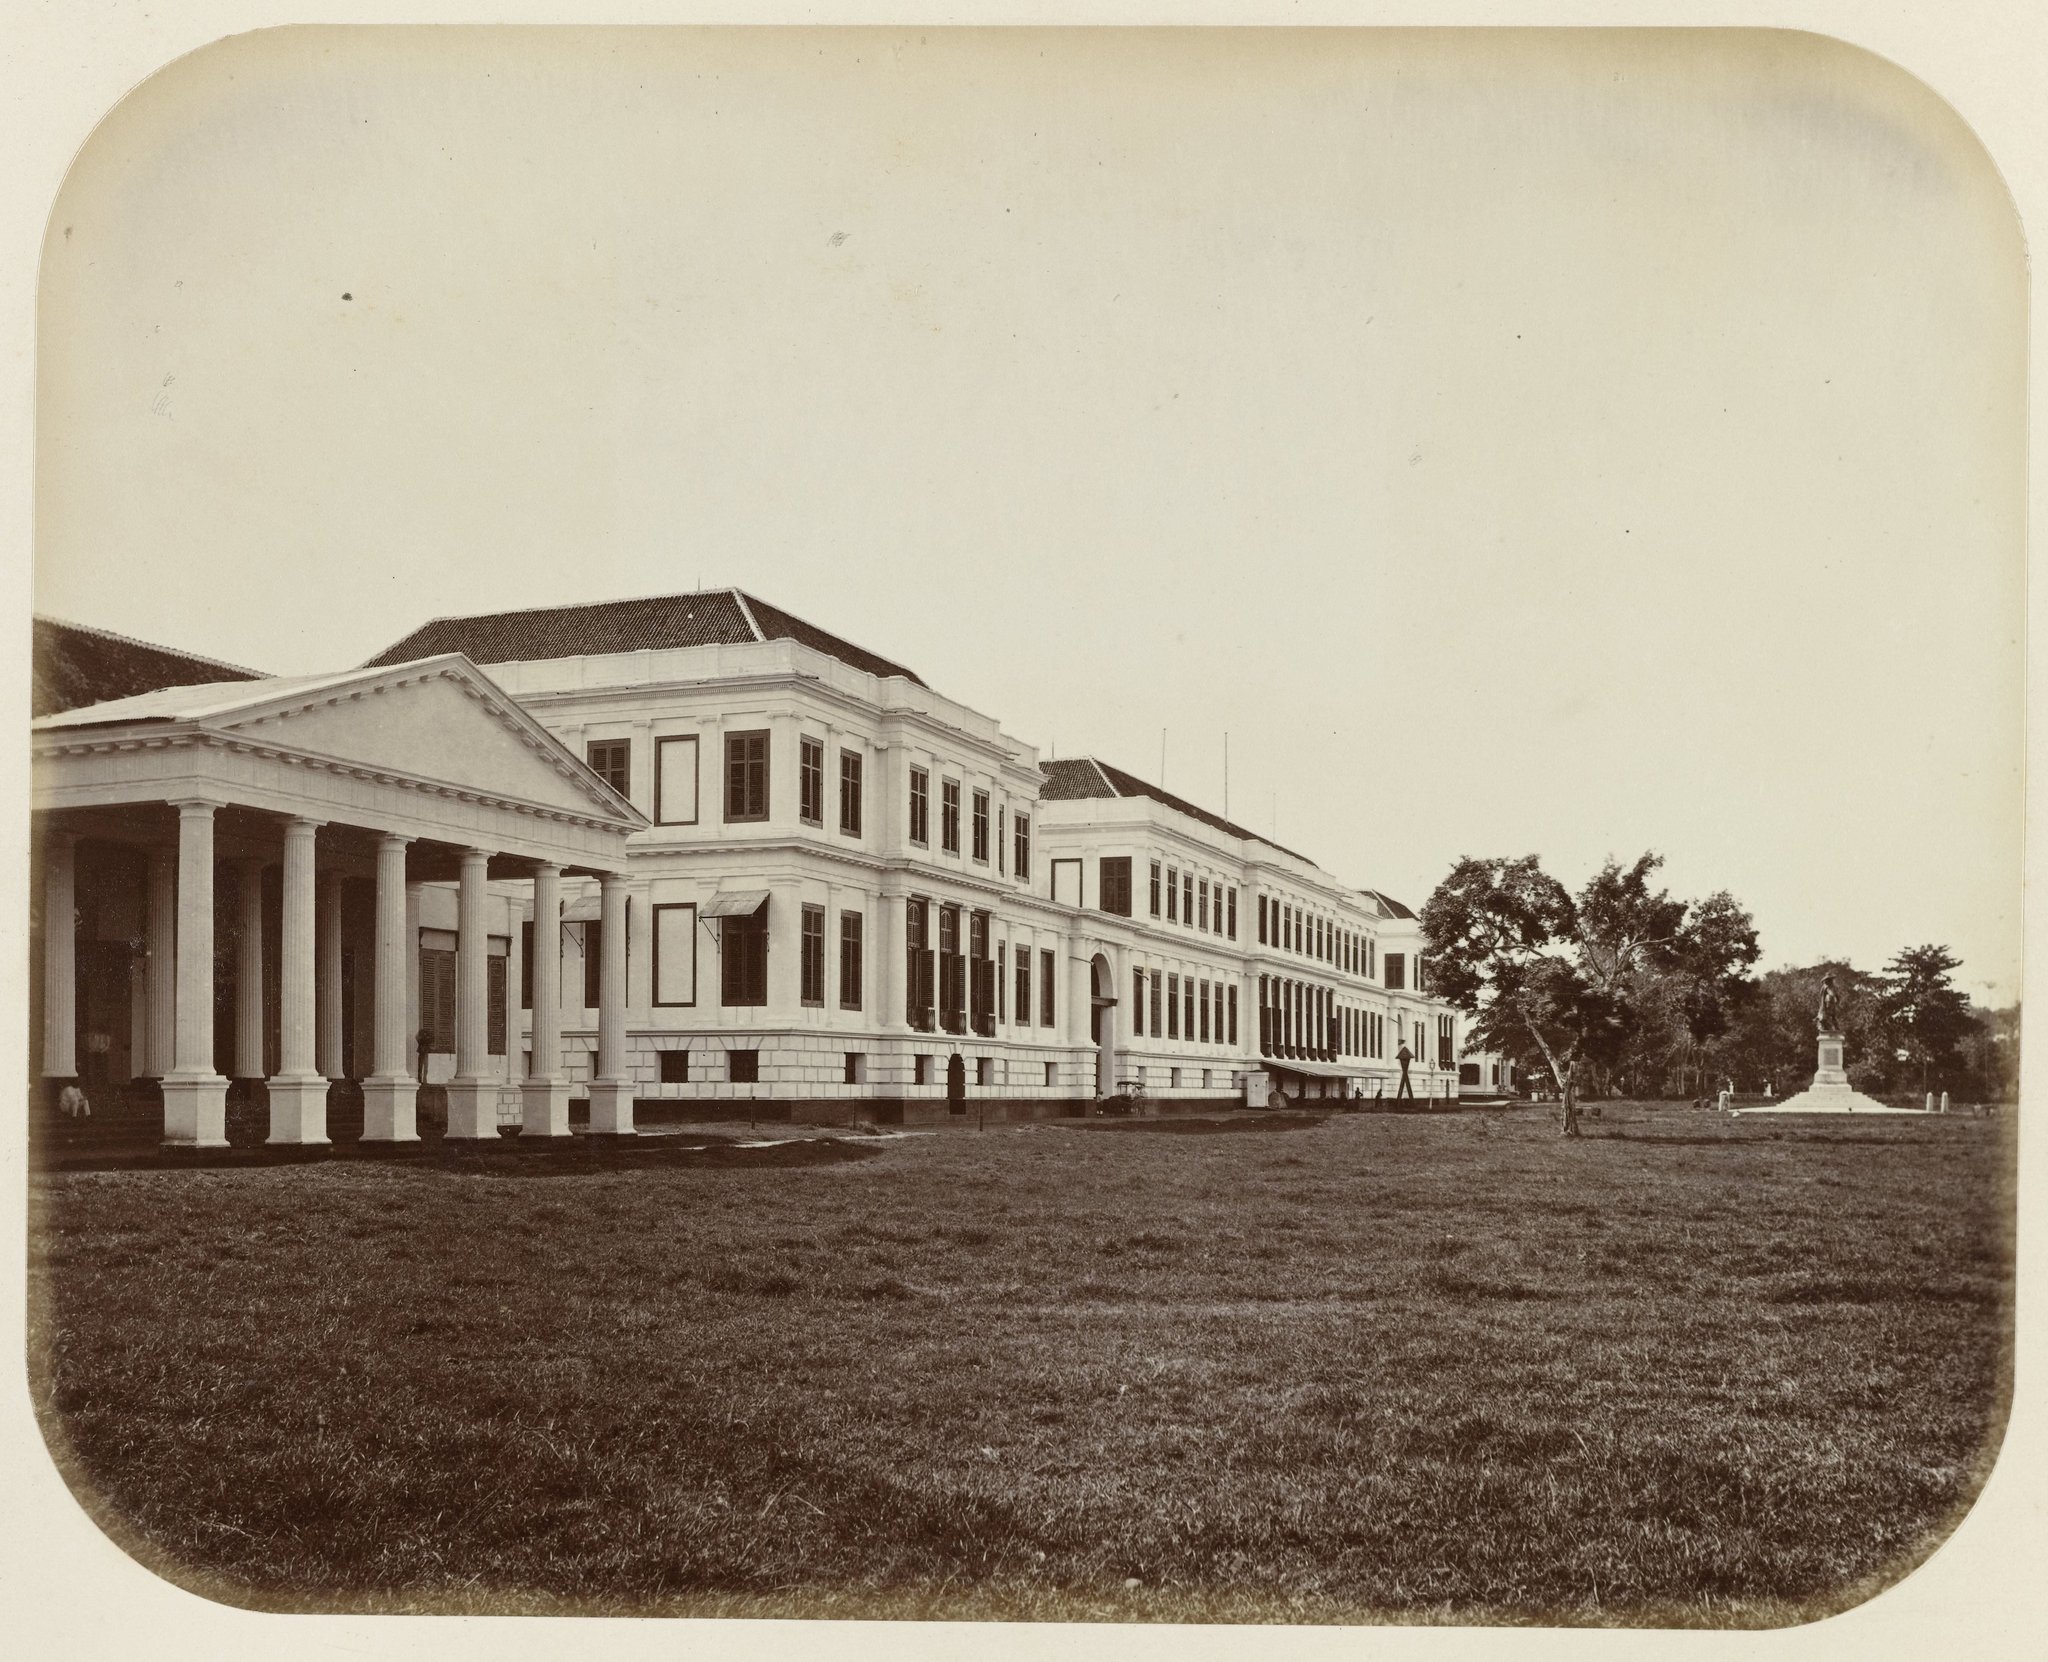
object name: photograph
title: Paleis van Daendels op het Waterlooplein te Batavia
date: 1875-1885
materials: photographic support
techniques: albumen print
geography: batavia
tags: palace, national government, java, batavia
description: Het paleis van Daendels gelegen aan het Waterlooplein in Weltevreden te Batavia, voor het paleis het standbeeld van J.P. Coen. Ingeplakte foto in het fotoalbum getiteld: Gezichten van Java.